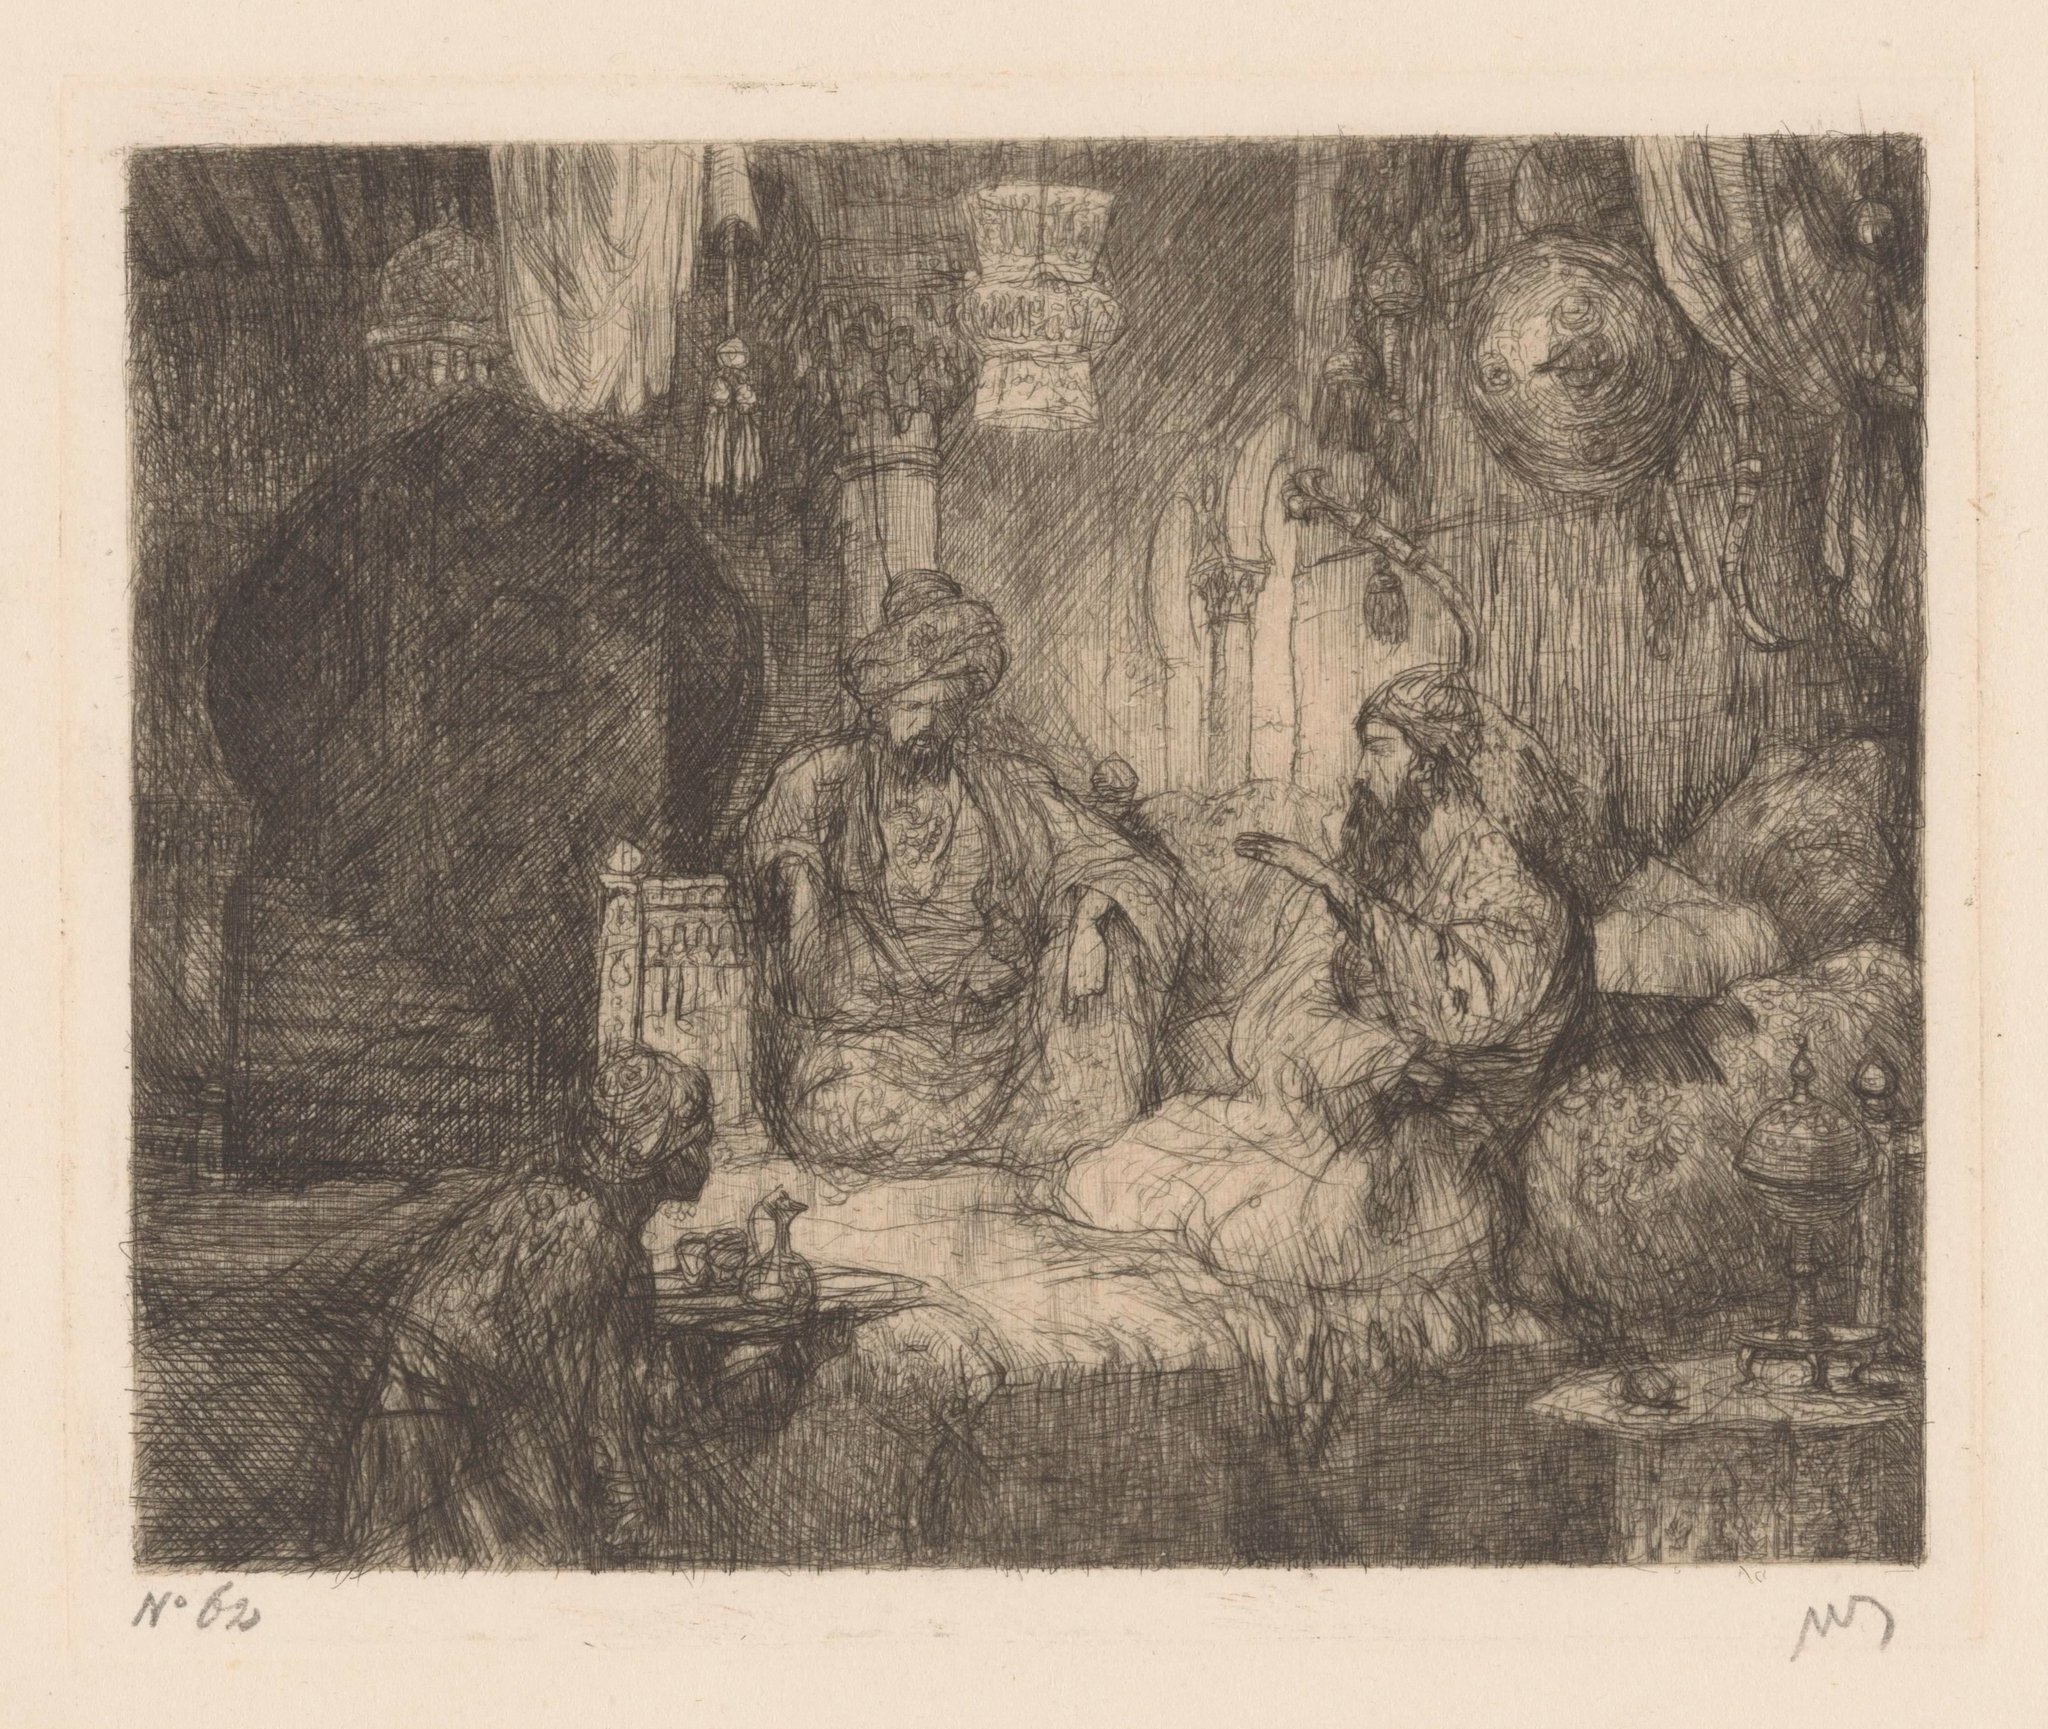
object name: print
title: Ottomaans interieur met twee mannen en dienaar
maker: marius bauer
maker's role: draughtsman, print maker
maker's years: 1867-1932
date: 1890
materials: paper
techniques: etching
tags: relation between master and servant, interior of the house, house personnel, servants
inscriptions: collector's mark: Lugt 2228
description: Twee mannen in oosterse kleding zittend in een kamer. Links op de voorgrond een jongen met een dienblad. Op de achtergrond een trapportaal.